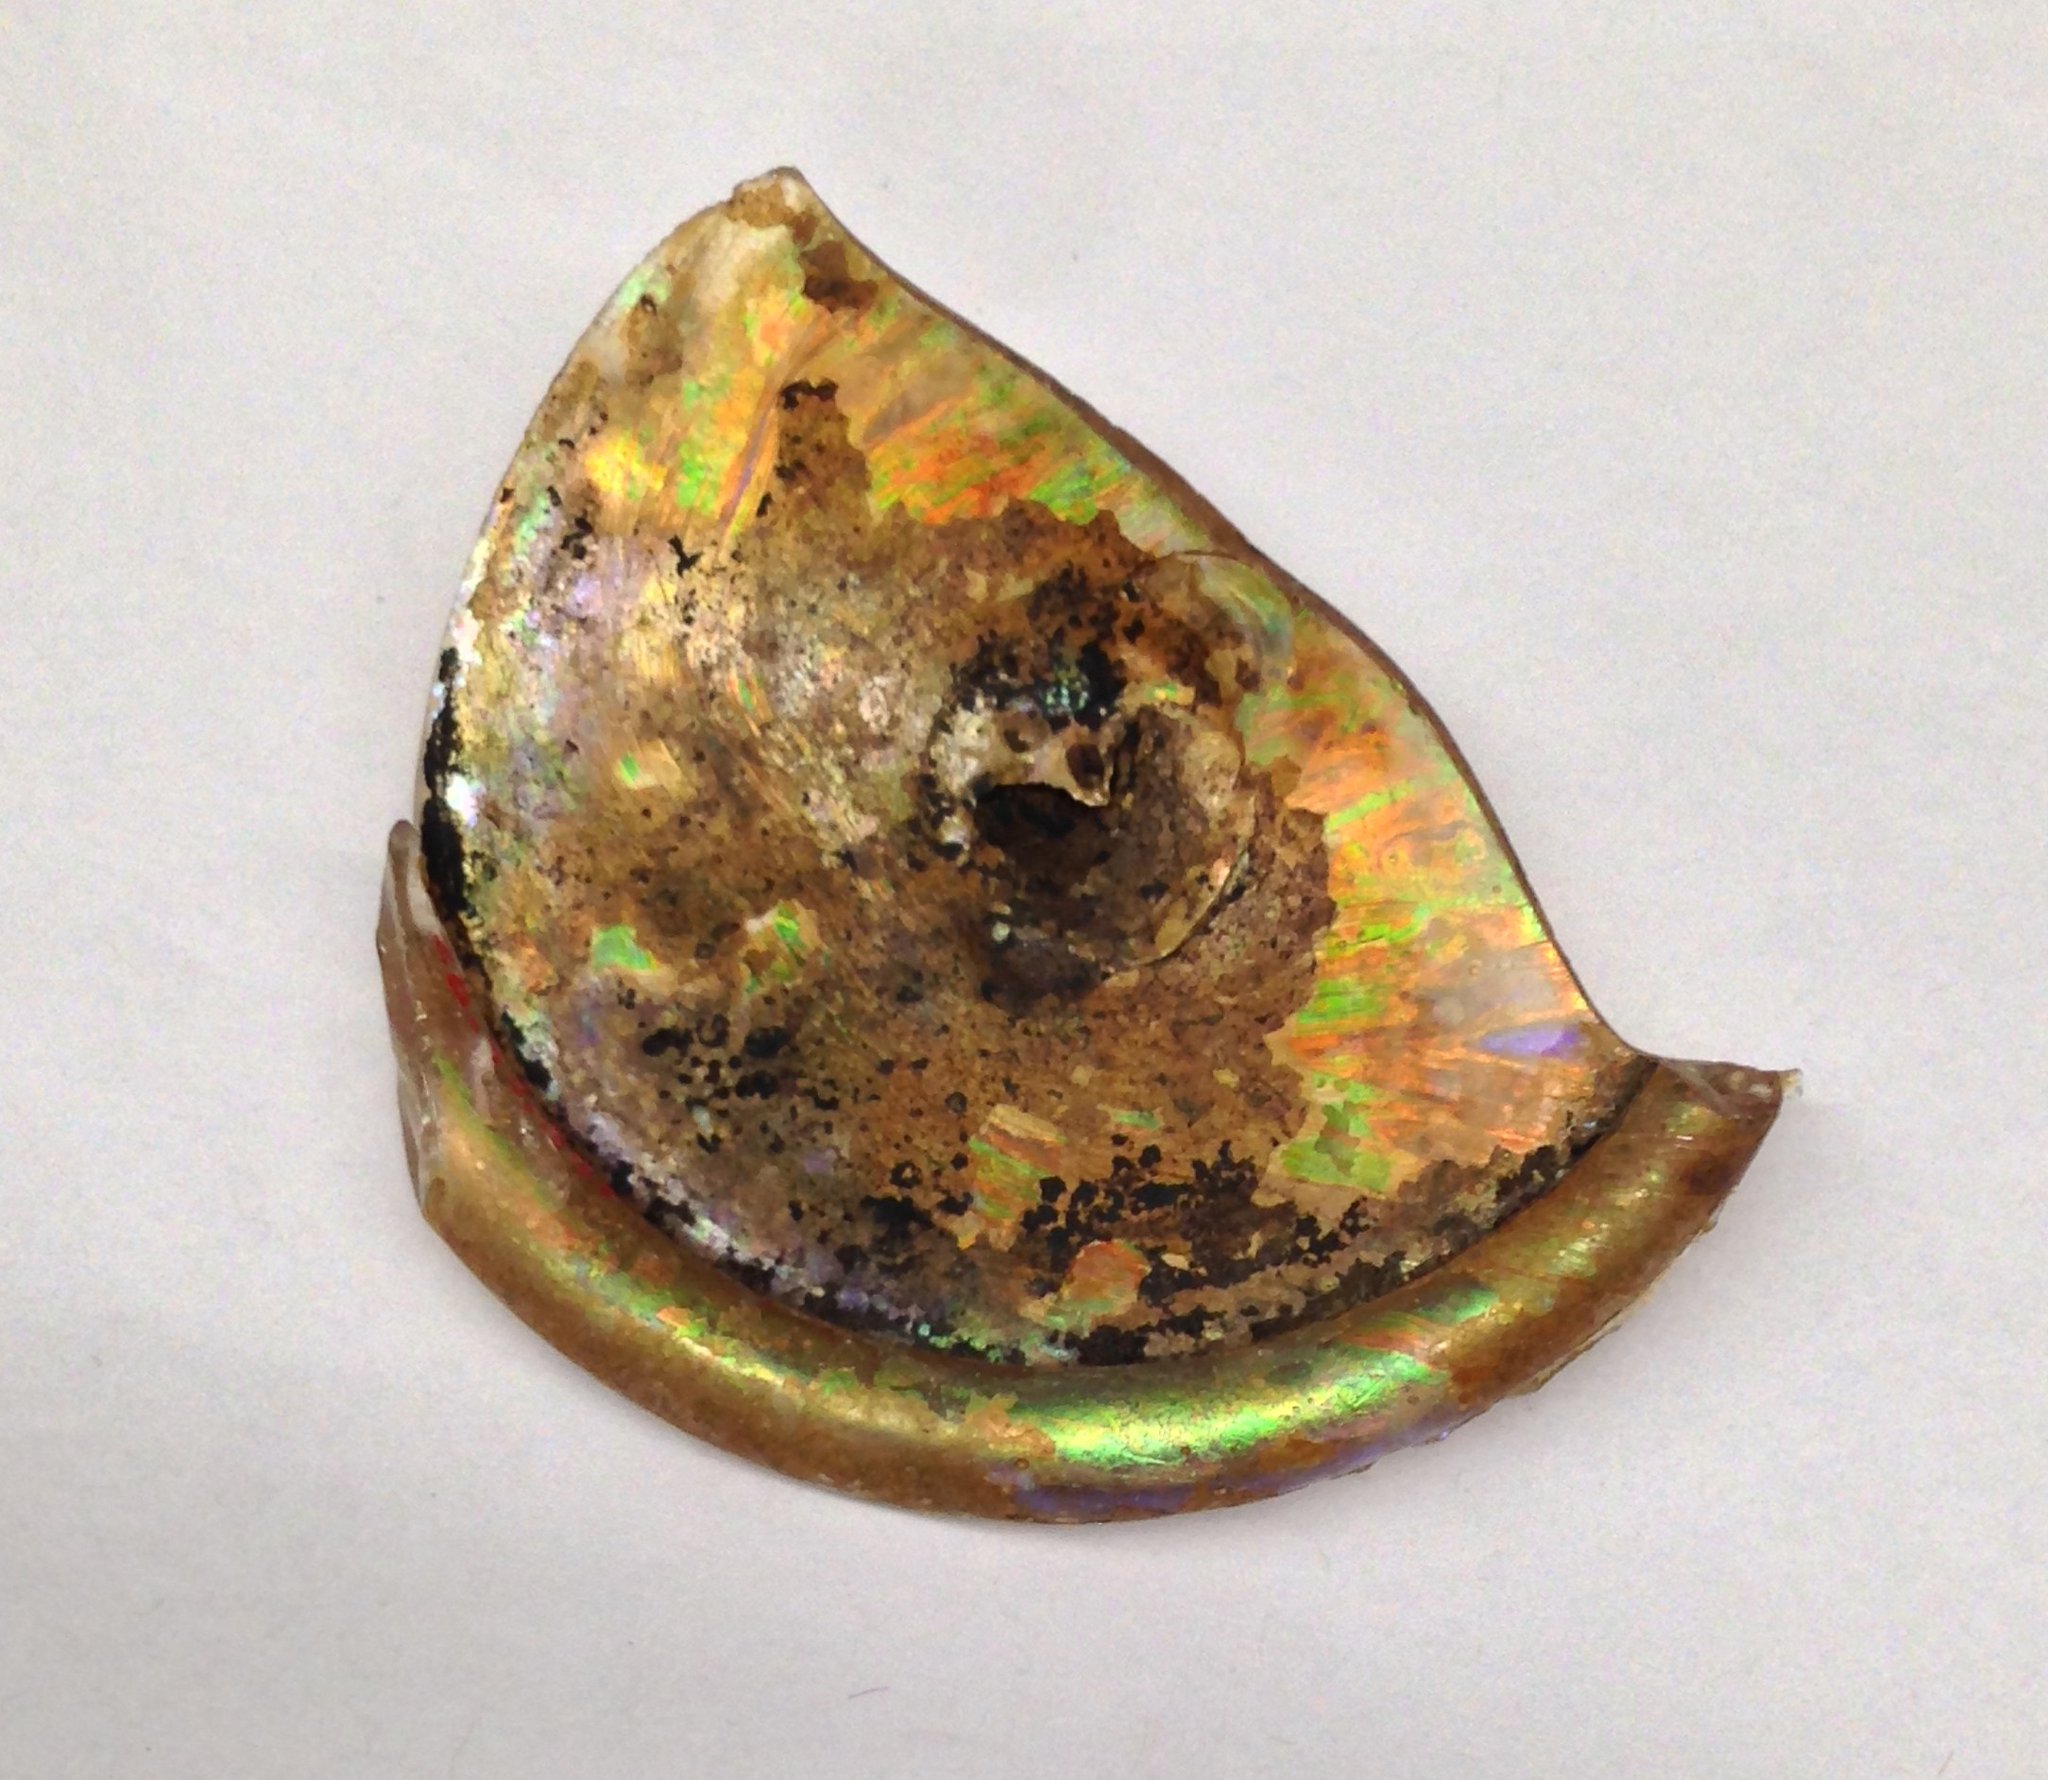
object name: fragment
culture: european or middle eastern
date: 1150-1250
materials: ceramic, glass